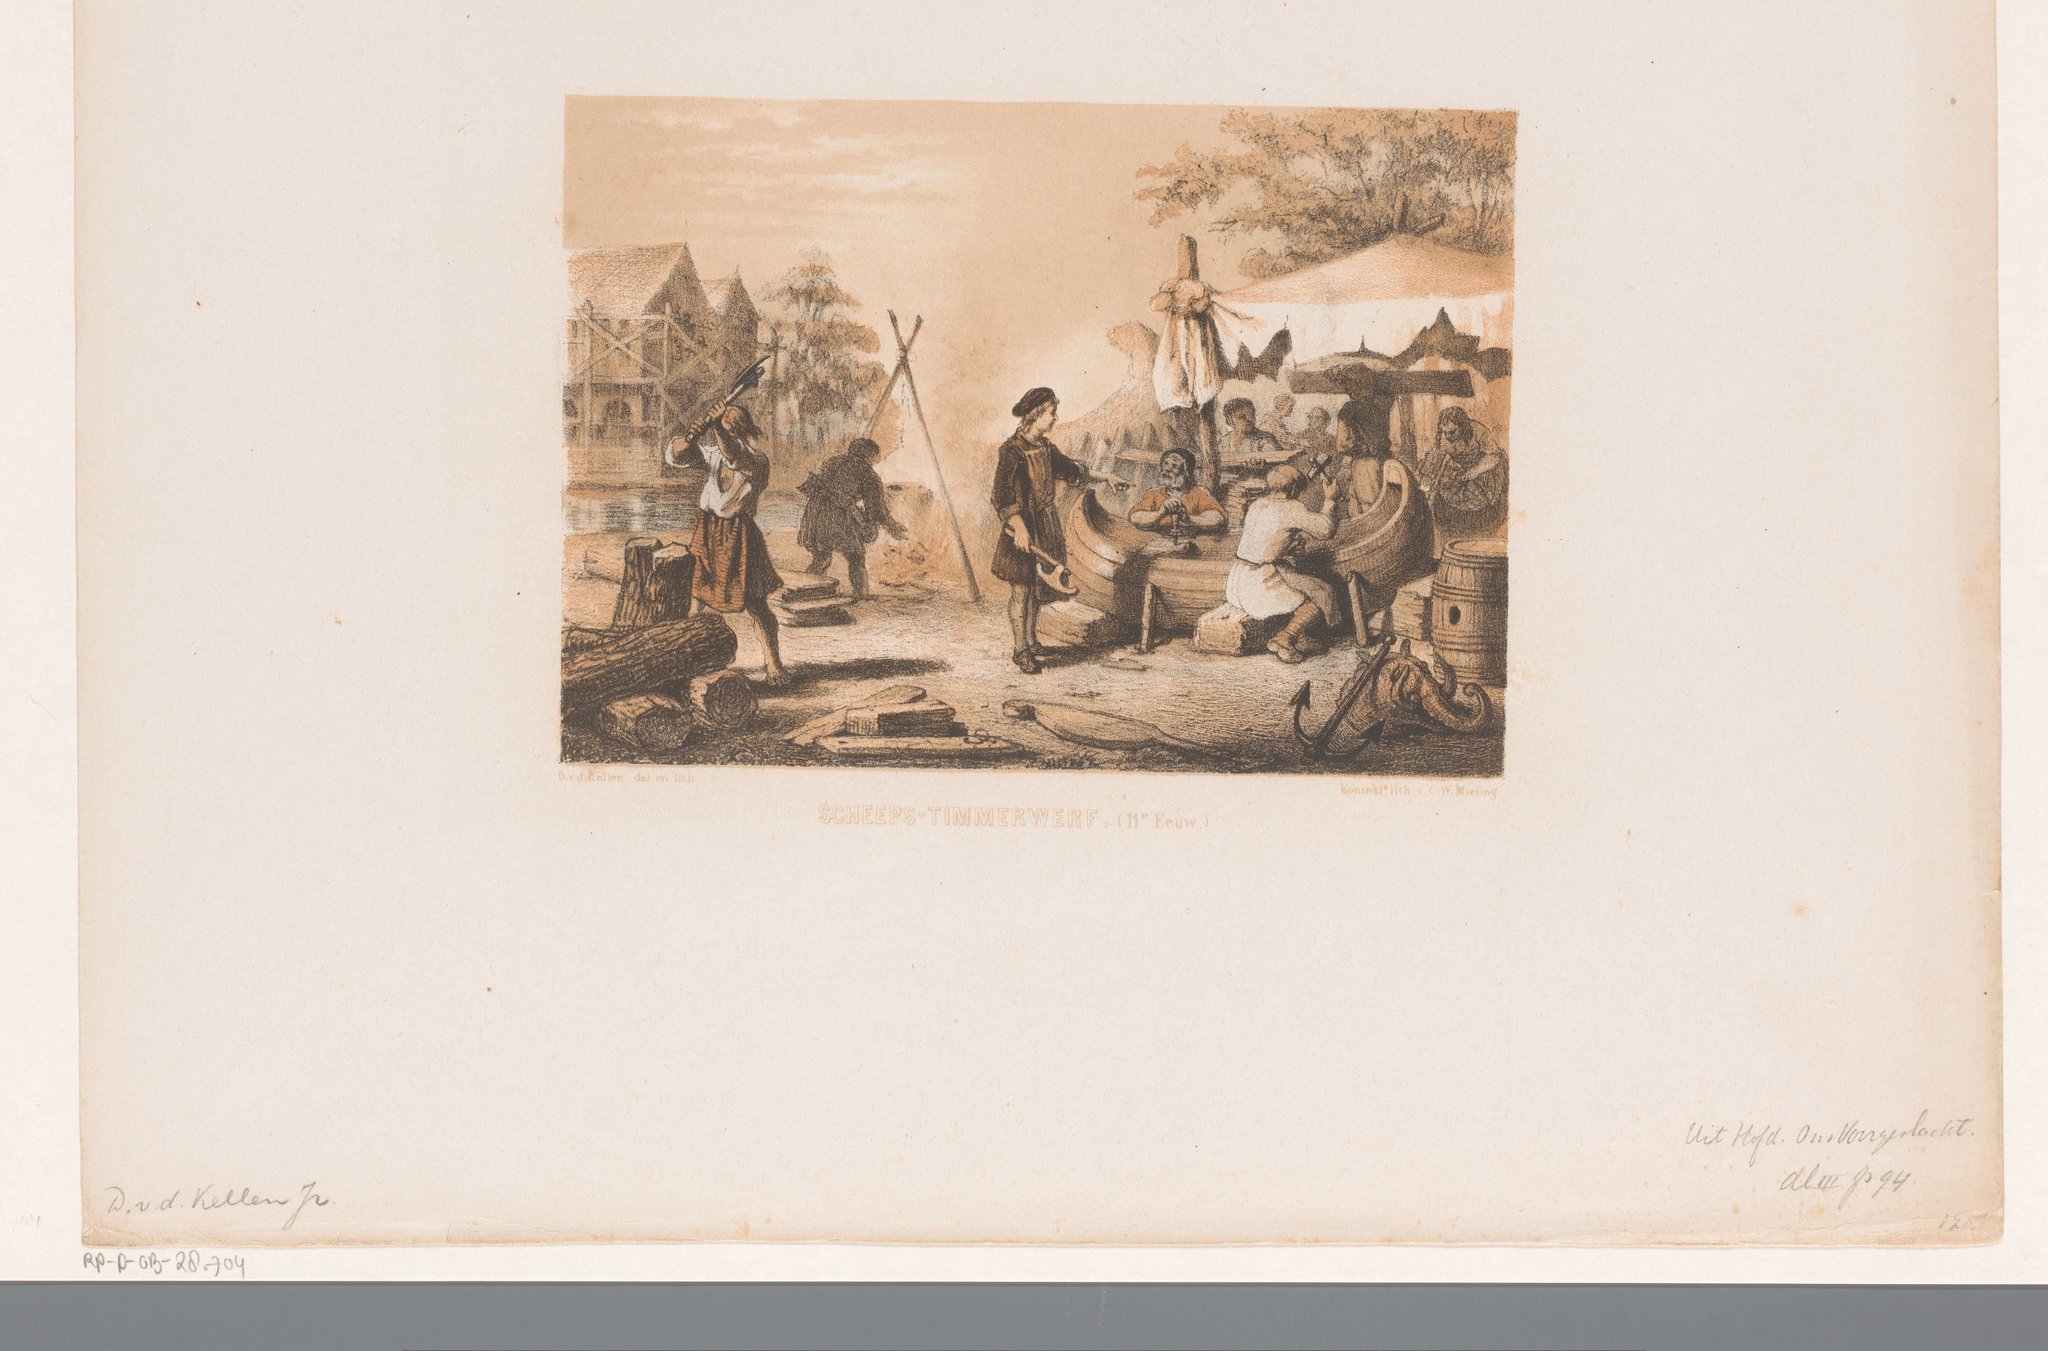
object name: print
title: Scheeps-Timmerwerf. (11e eeuw)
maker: david van der kellen (1827-1895)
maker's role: draughtsman, print maker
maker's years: 1827-1895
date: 1857-1864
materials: paper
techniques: tone lithography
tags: shipbuilding industry, netherlands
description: Een scheepstimmerwerf met scheepsbouw in de 11e eeuw. Verschillende werklieden werken aan een kleine boot, links wordt hout gehakt.